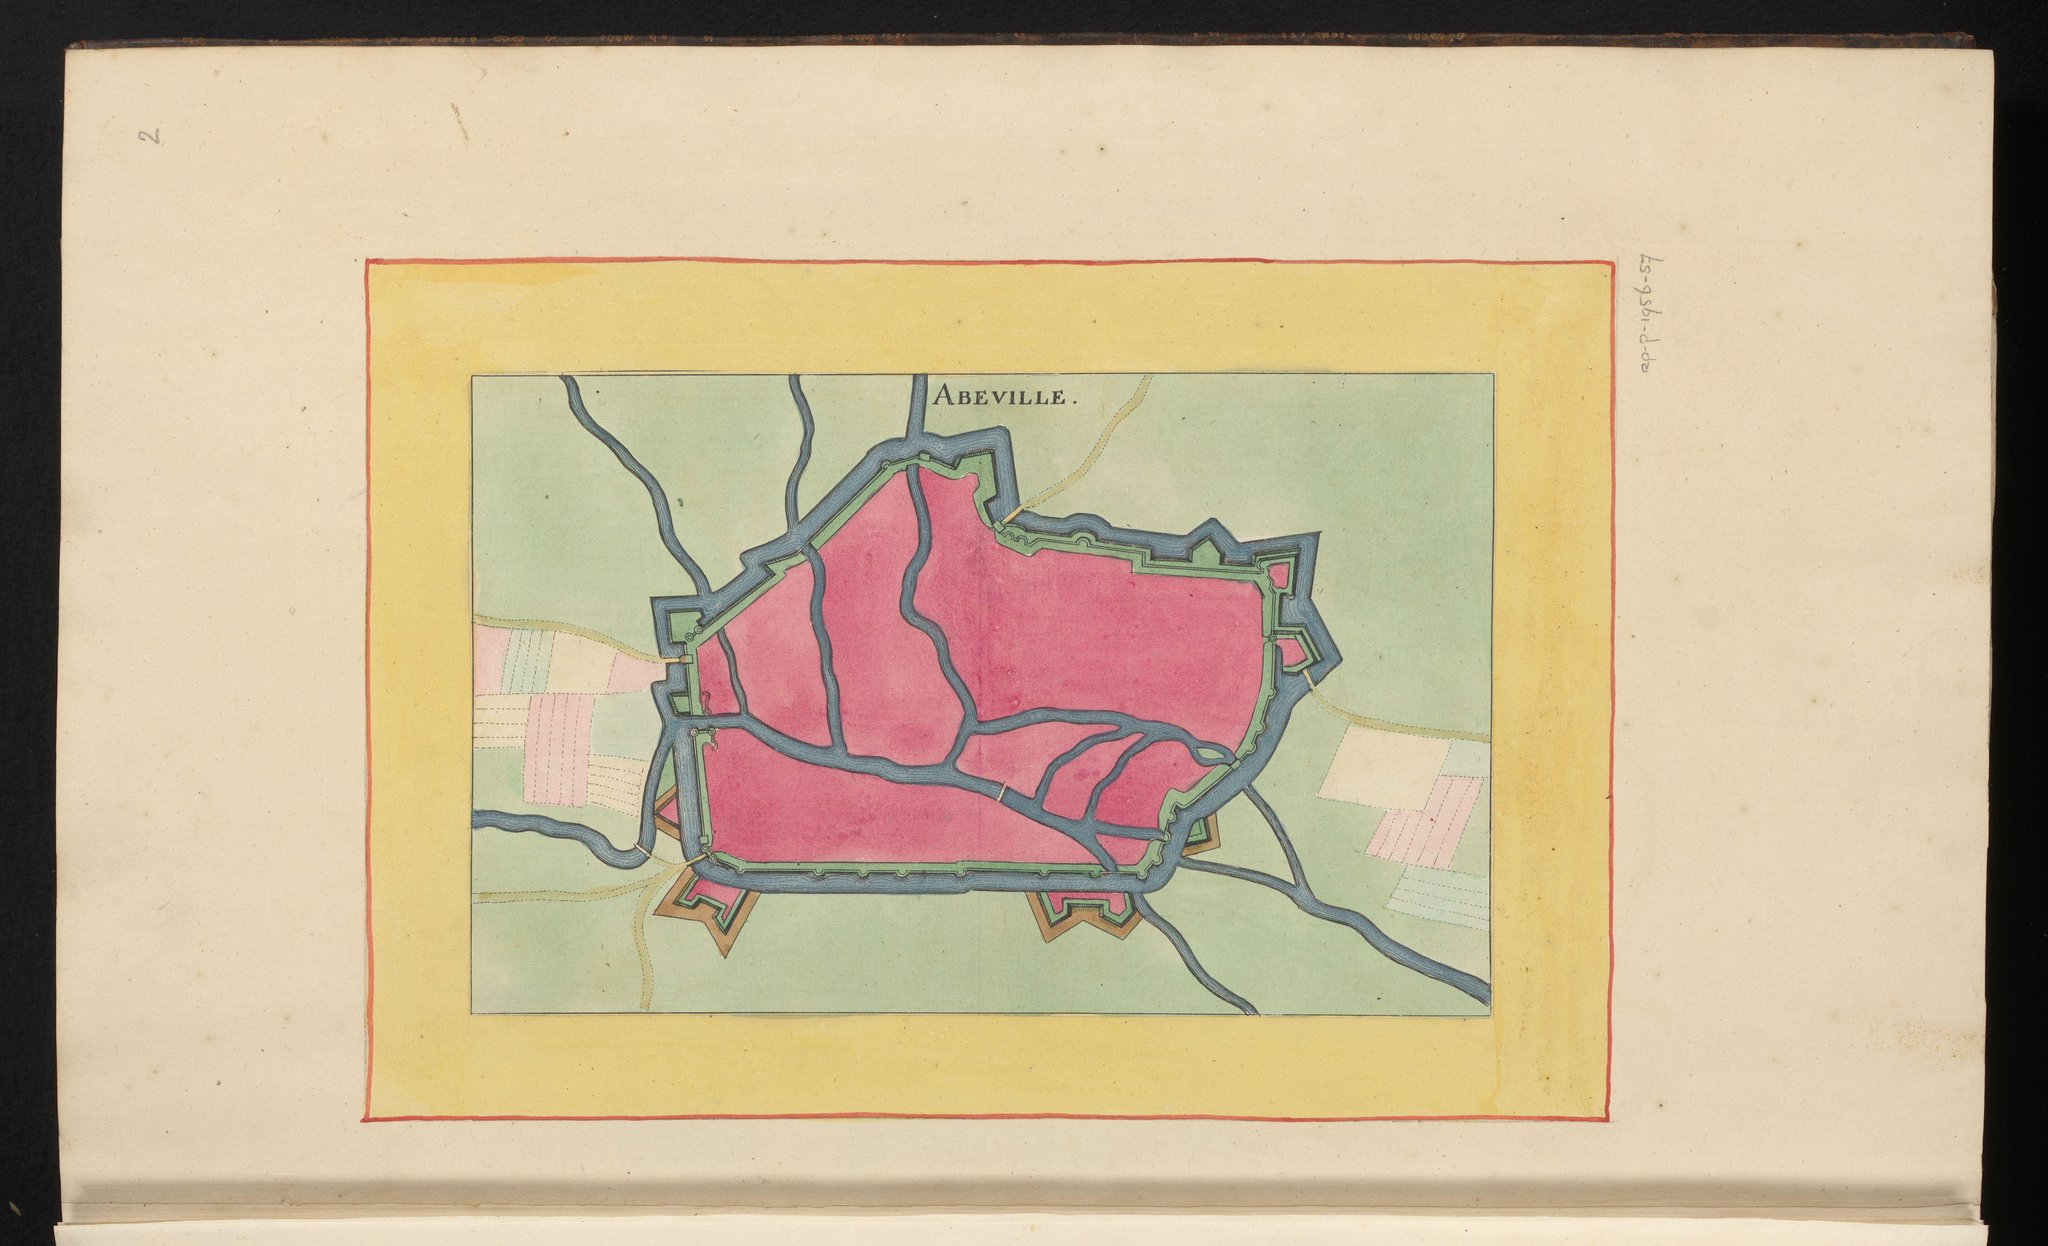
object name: area plan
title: Abeville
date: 1656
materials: paper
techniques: engraving, etching, hand coloring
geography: the hague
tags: maps of cities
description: Kaart uit: Zeiller, Martin. Topographia Galliae. 13 dln. Frankfurt: Caspar Merian, 1656, dl. 2, na p. 14.